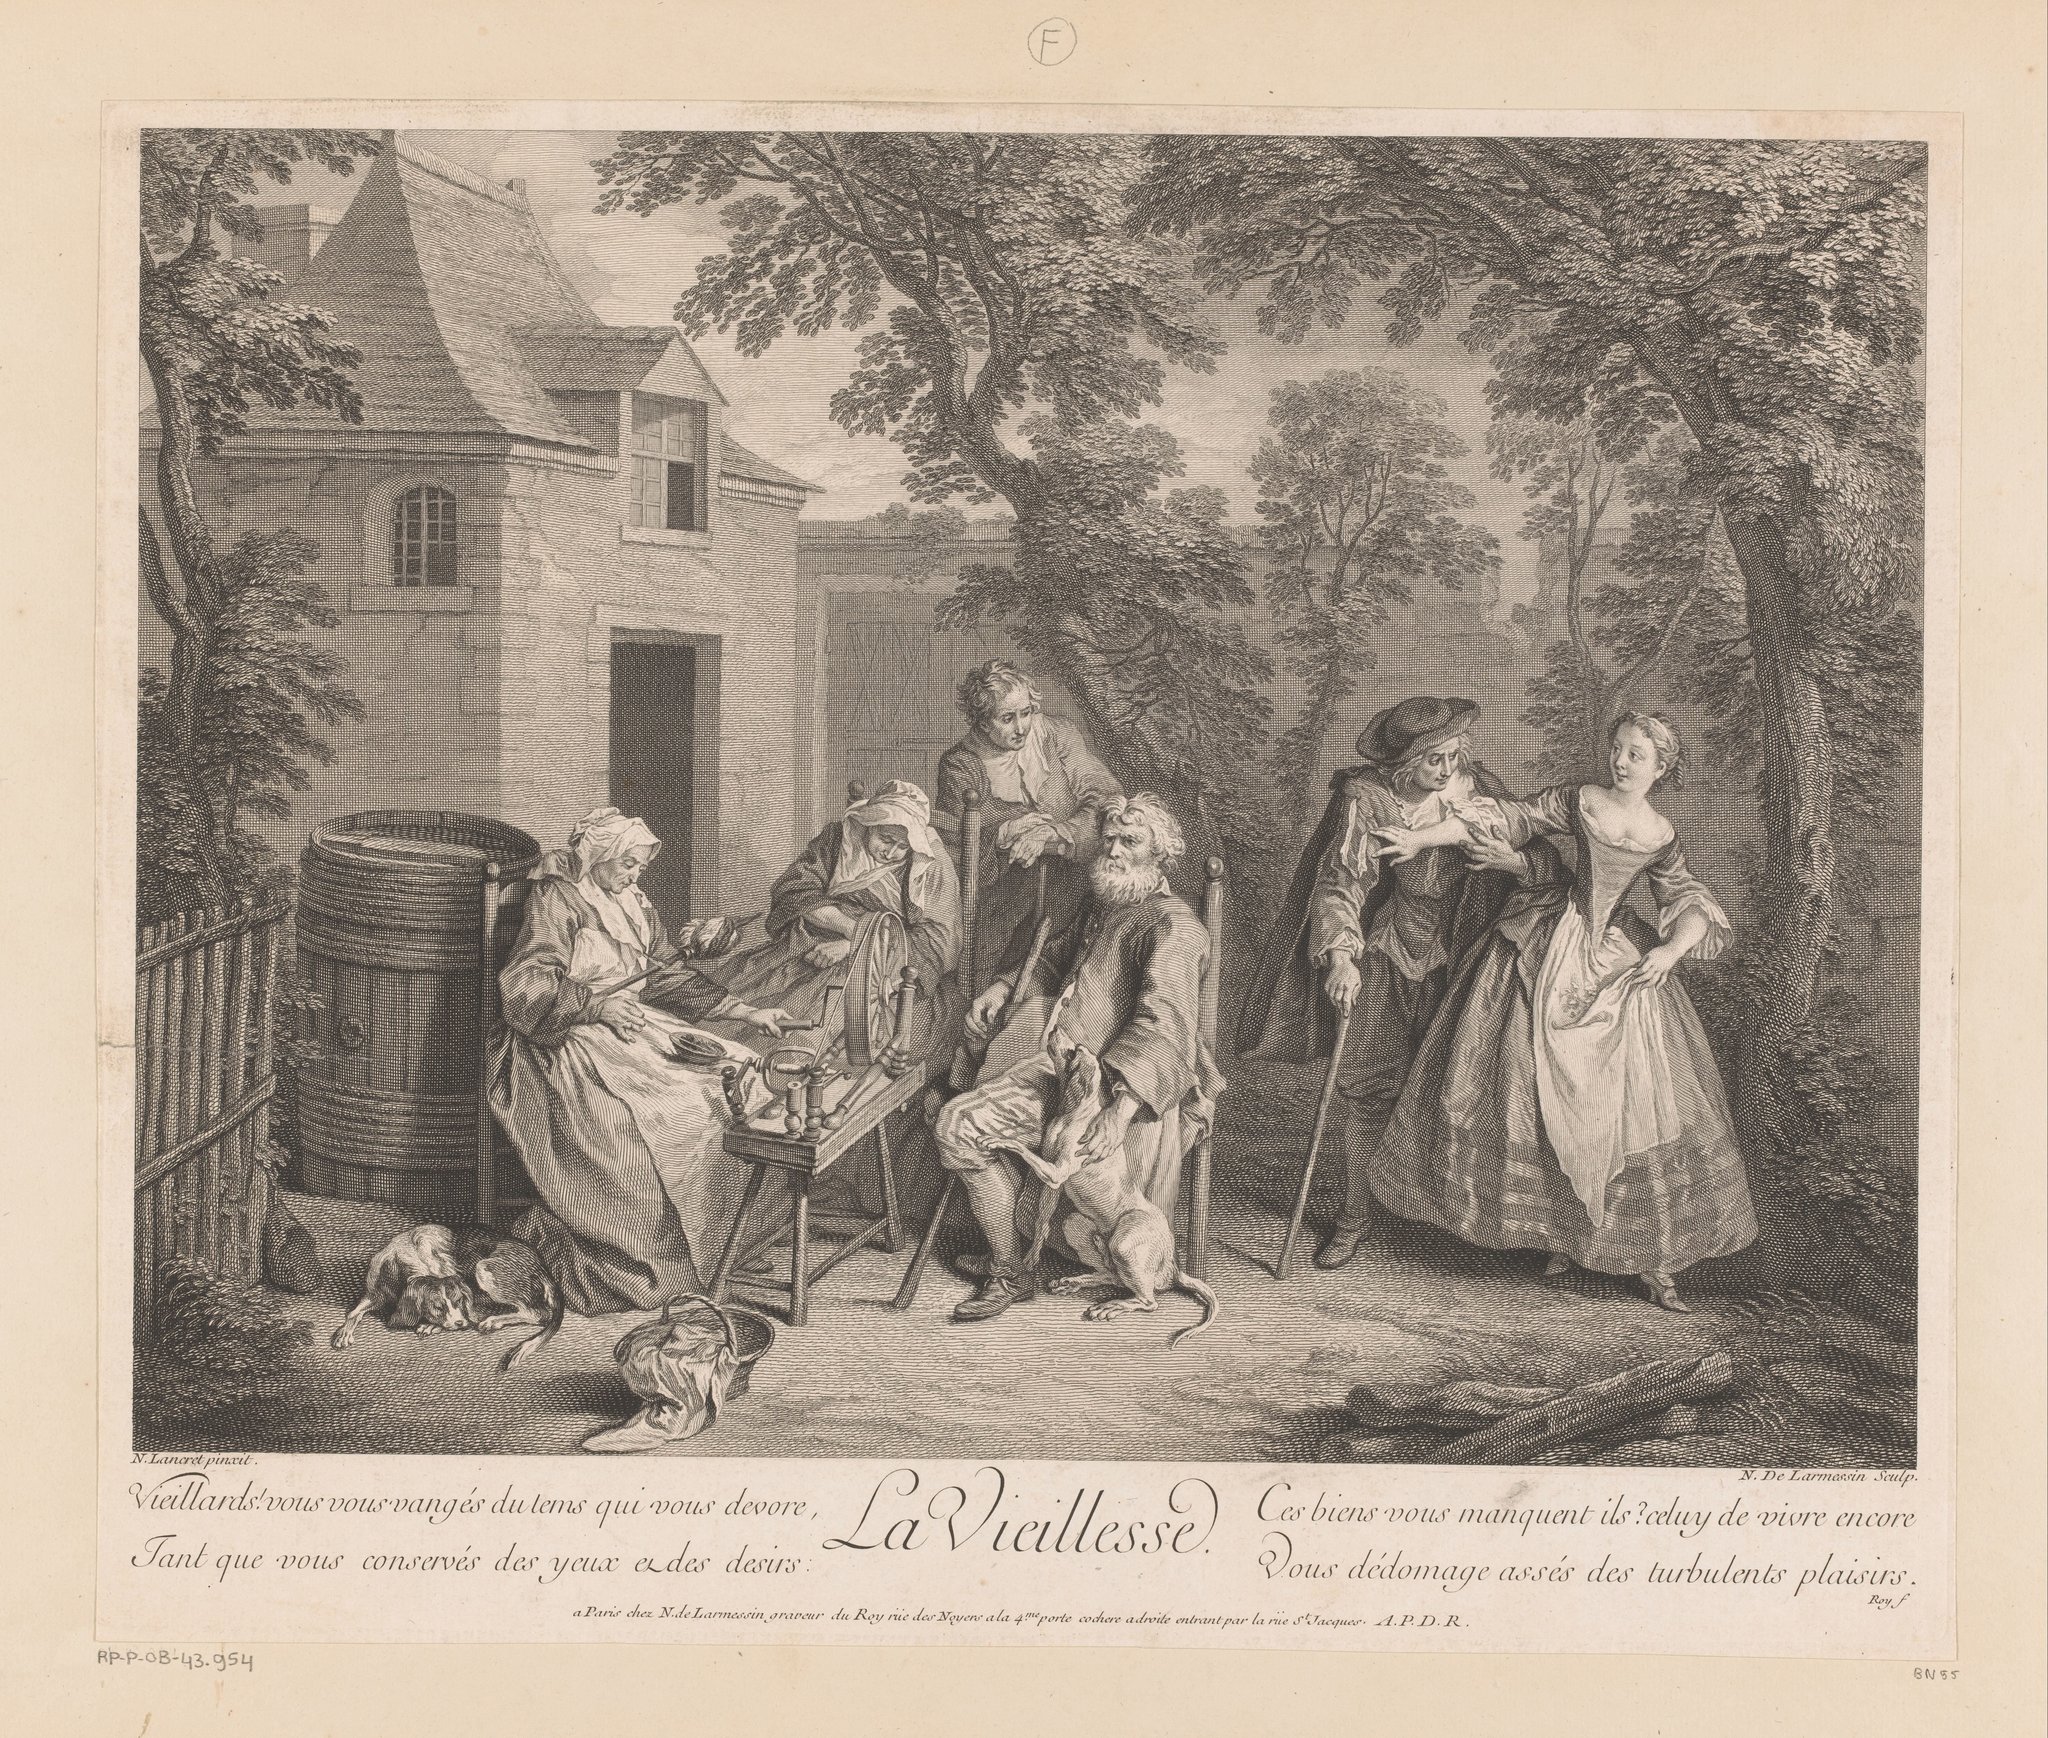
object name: print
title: Quatre âges de la Vie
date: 1735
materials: paper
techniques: engraving, etching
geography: paris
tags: old age, 'senectus'; 'vecchiezza' (ripa)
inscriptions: watermark, collector's mark: Lugt 240